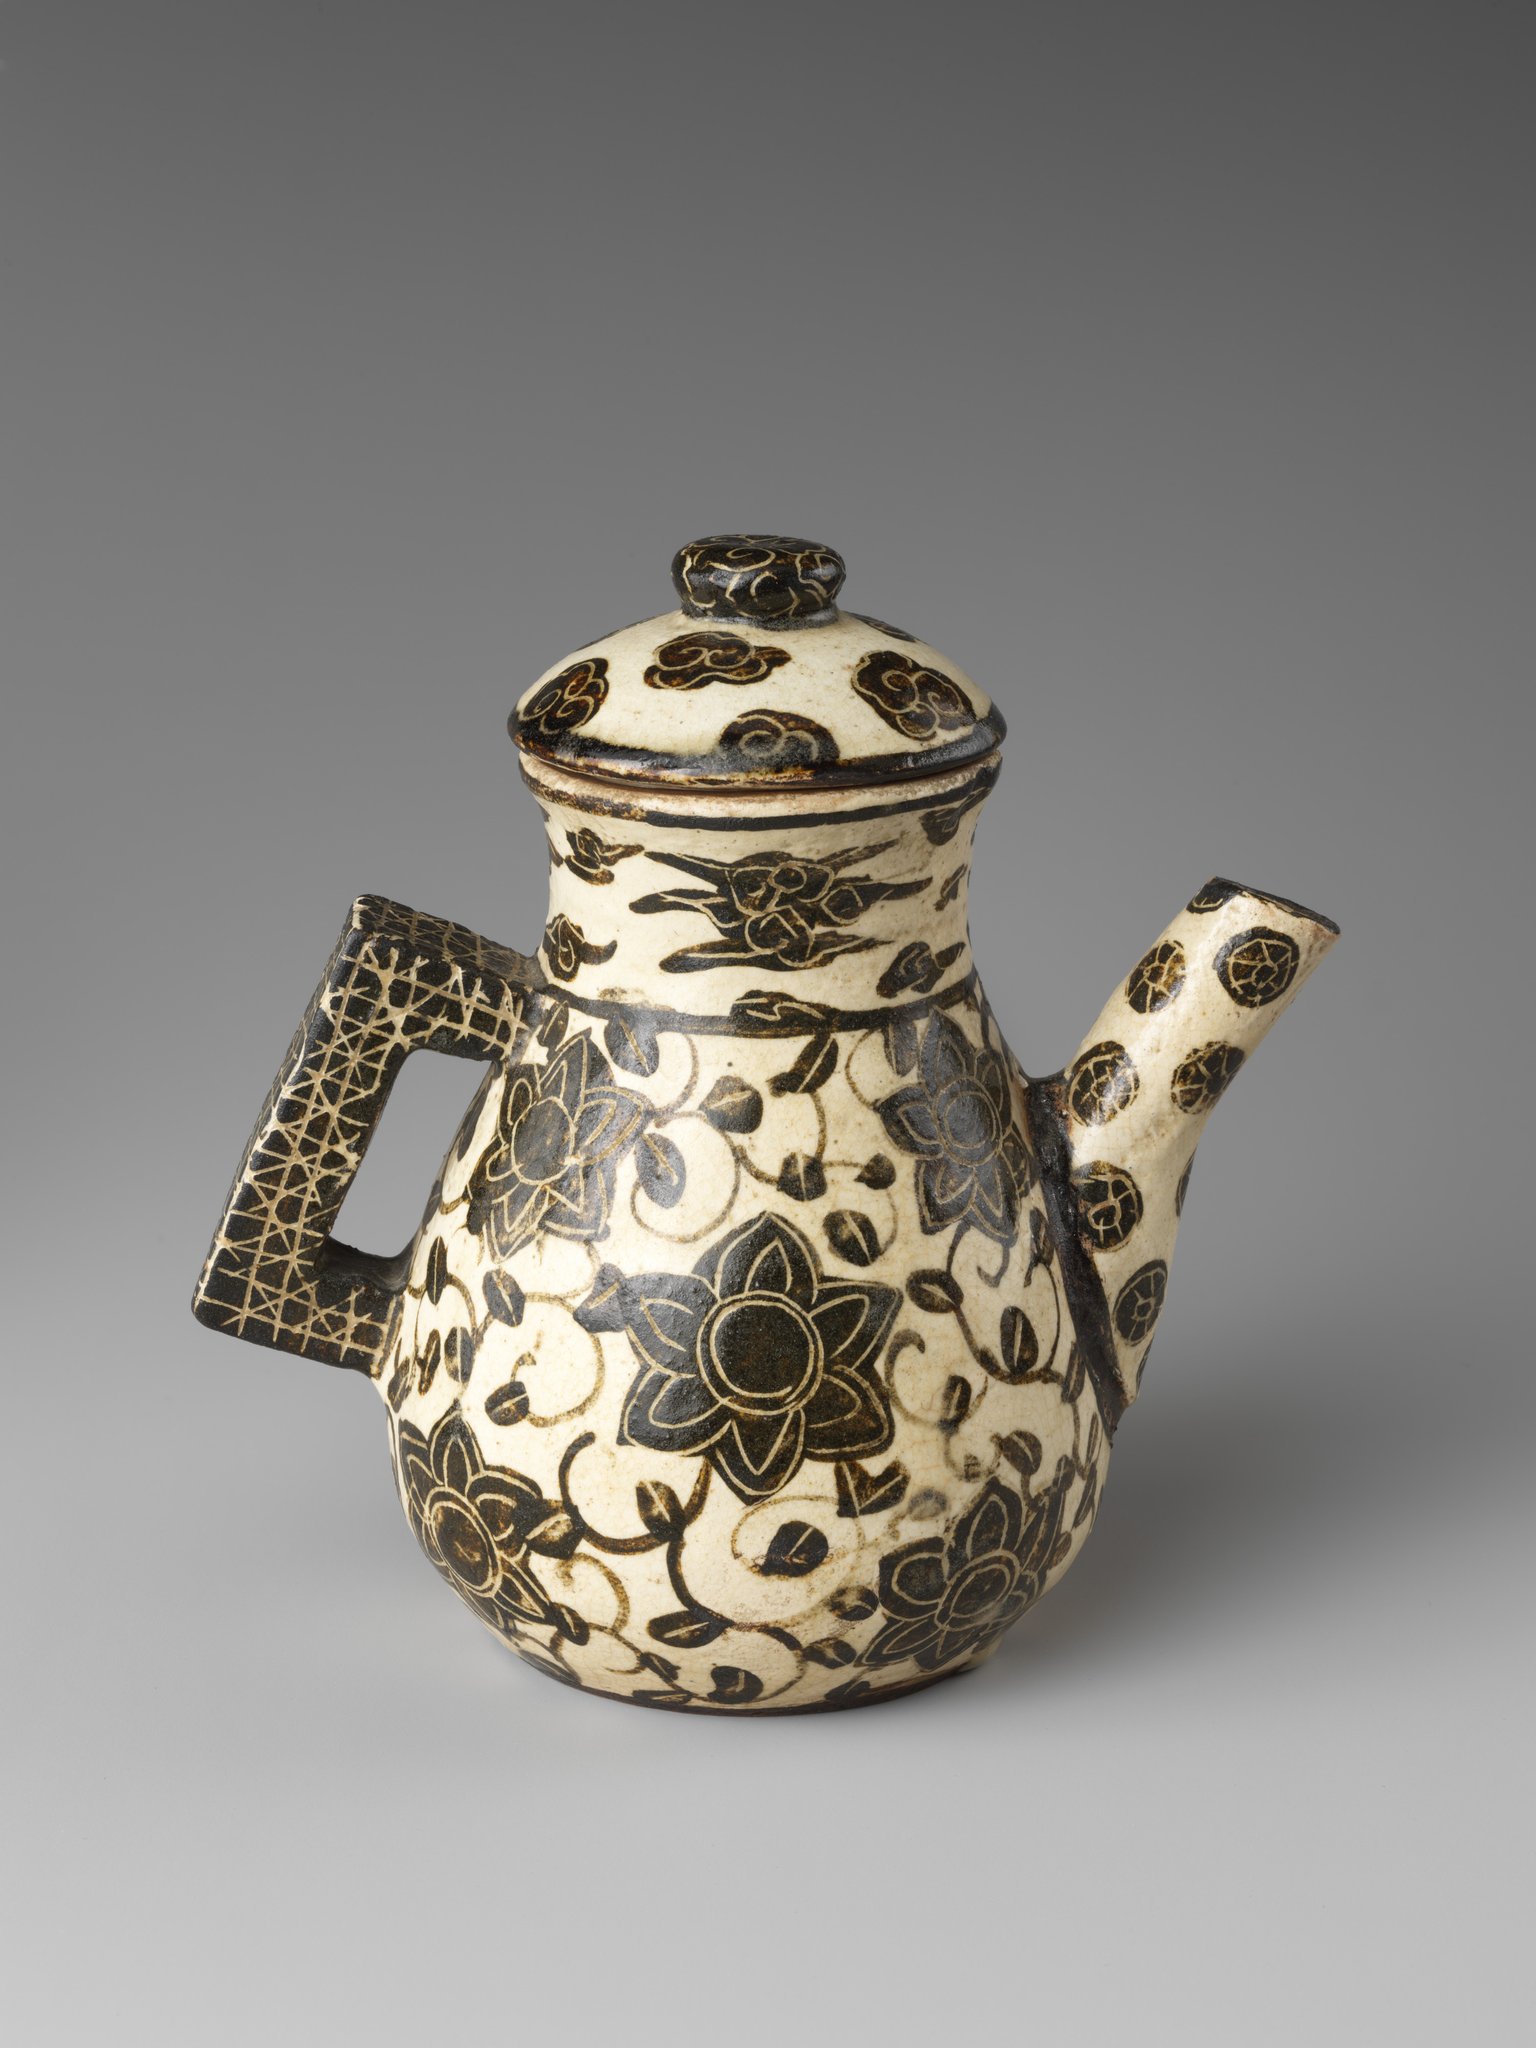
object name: vessel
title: Spouted pouring vessel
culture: japanese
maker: ogata kenzan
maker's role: artist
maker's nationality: japanese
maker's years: 1663-1743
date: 1615-1868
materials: earthenware, iron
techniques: underglaze